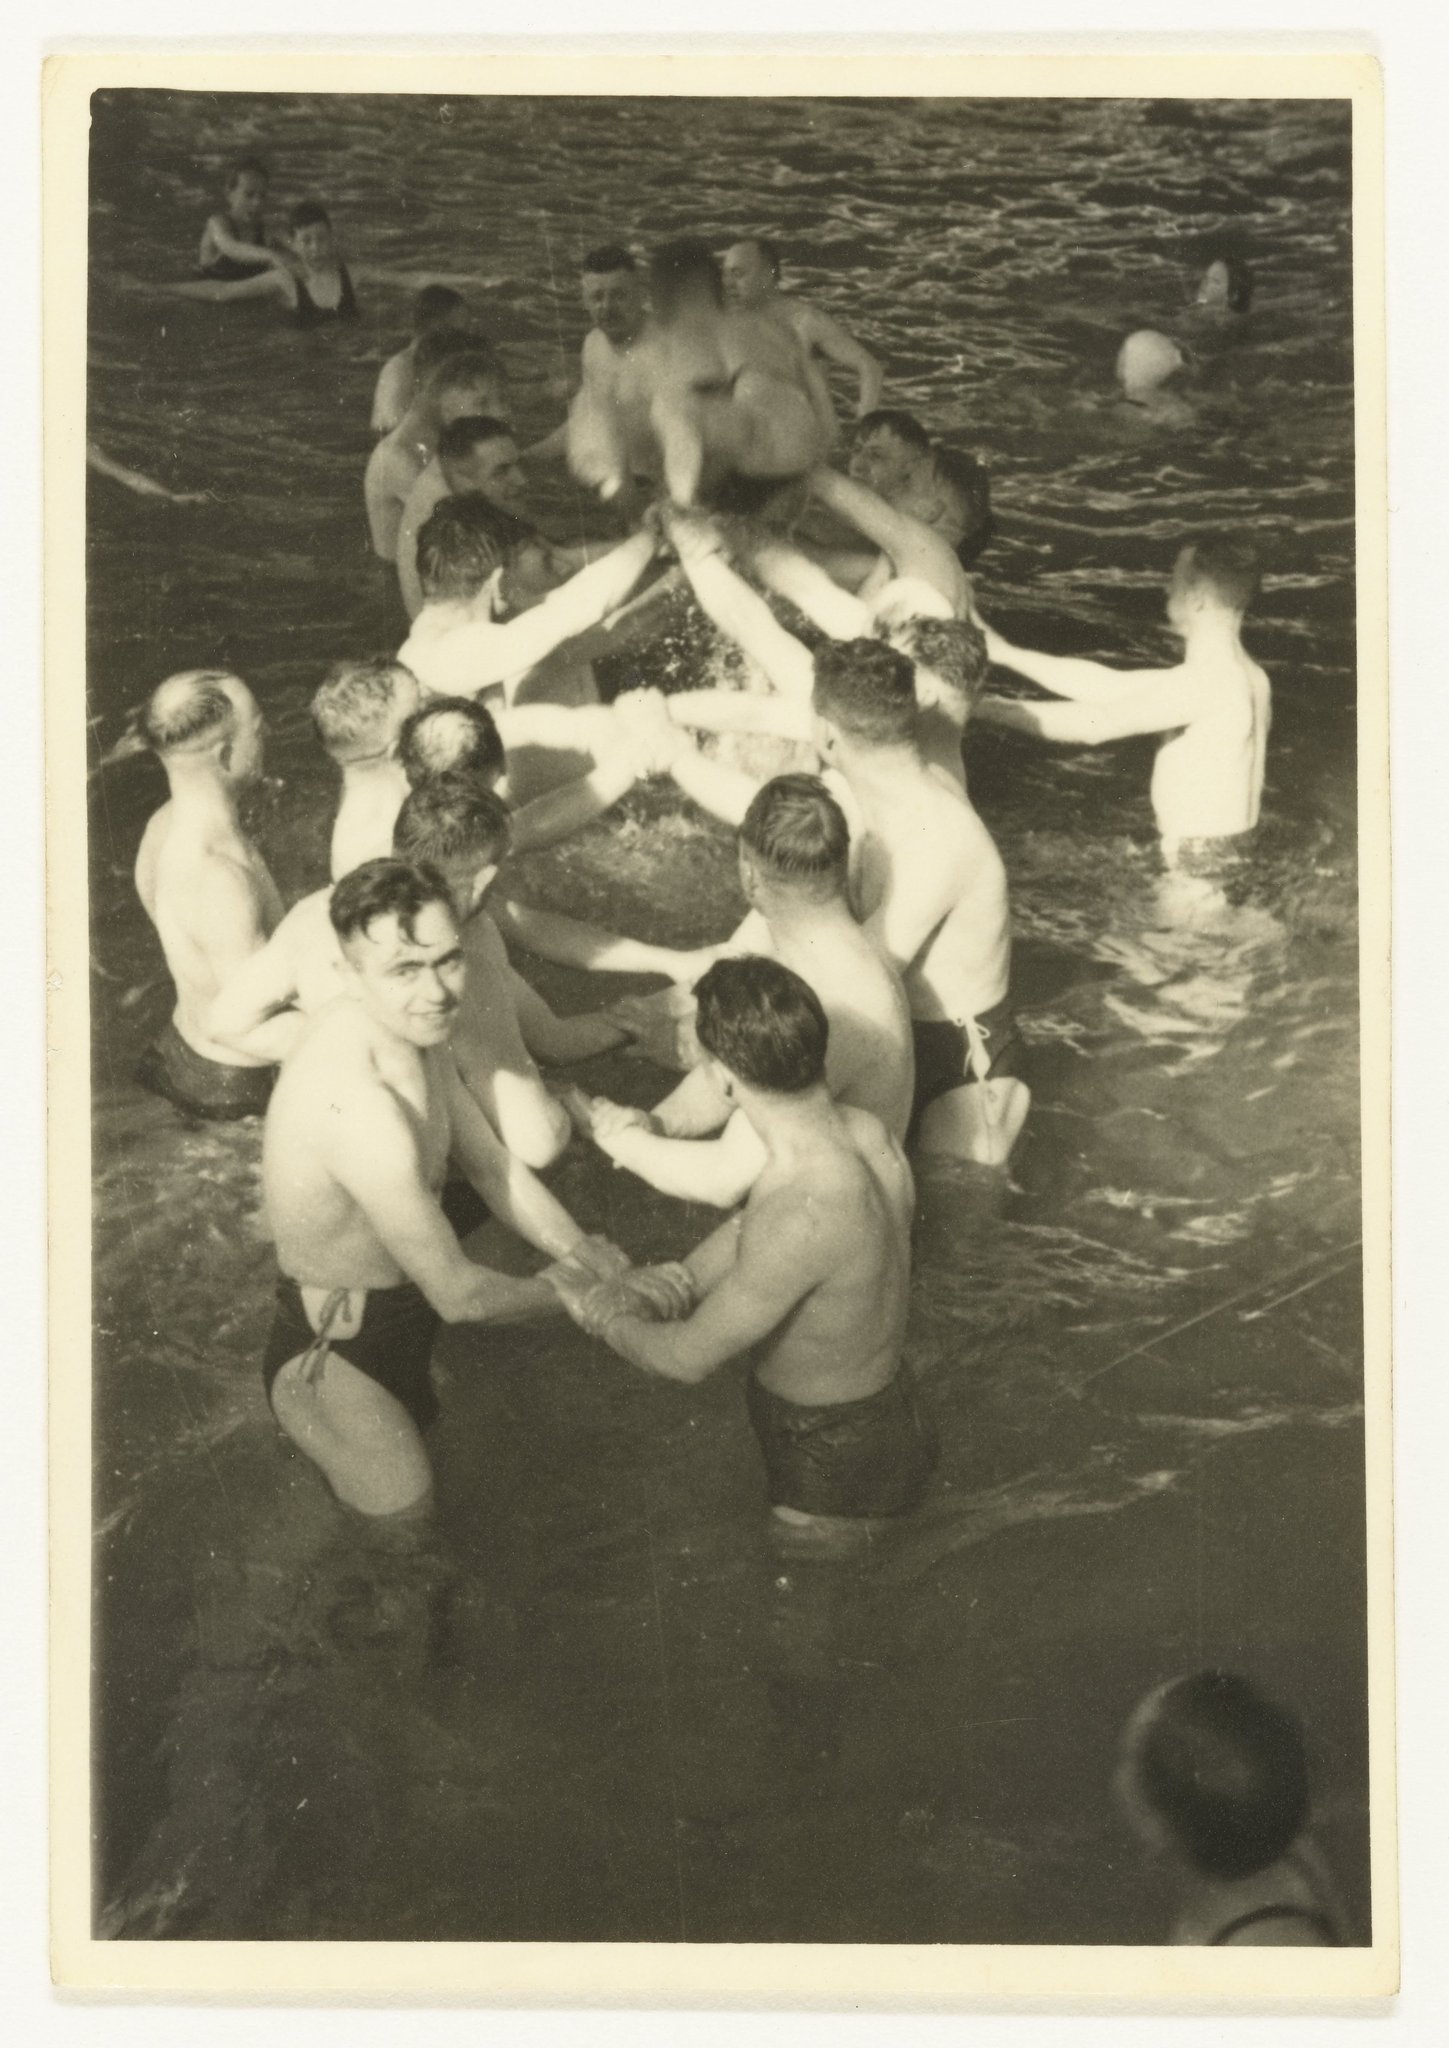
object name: photograph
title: Soldaten in zee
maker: Anonymous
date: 1942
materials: photographic support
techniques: gelatin silver print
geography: bergen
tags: recreation ~ the soldier off duty, occupation ~ war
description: Wehrmachtsoldaten vermaken zich in zee. Waarschijnlijk 1942 in Bergen aan Zee.